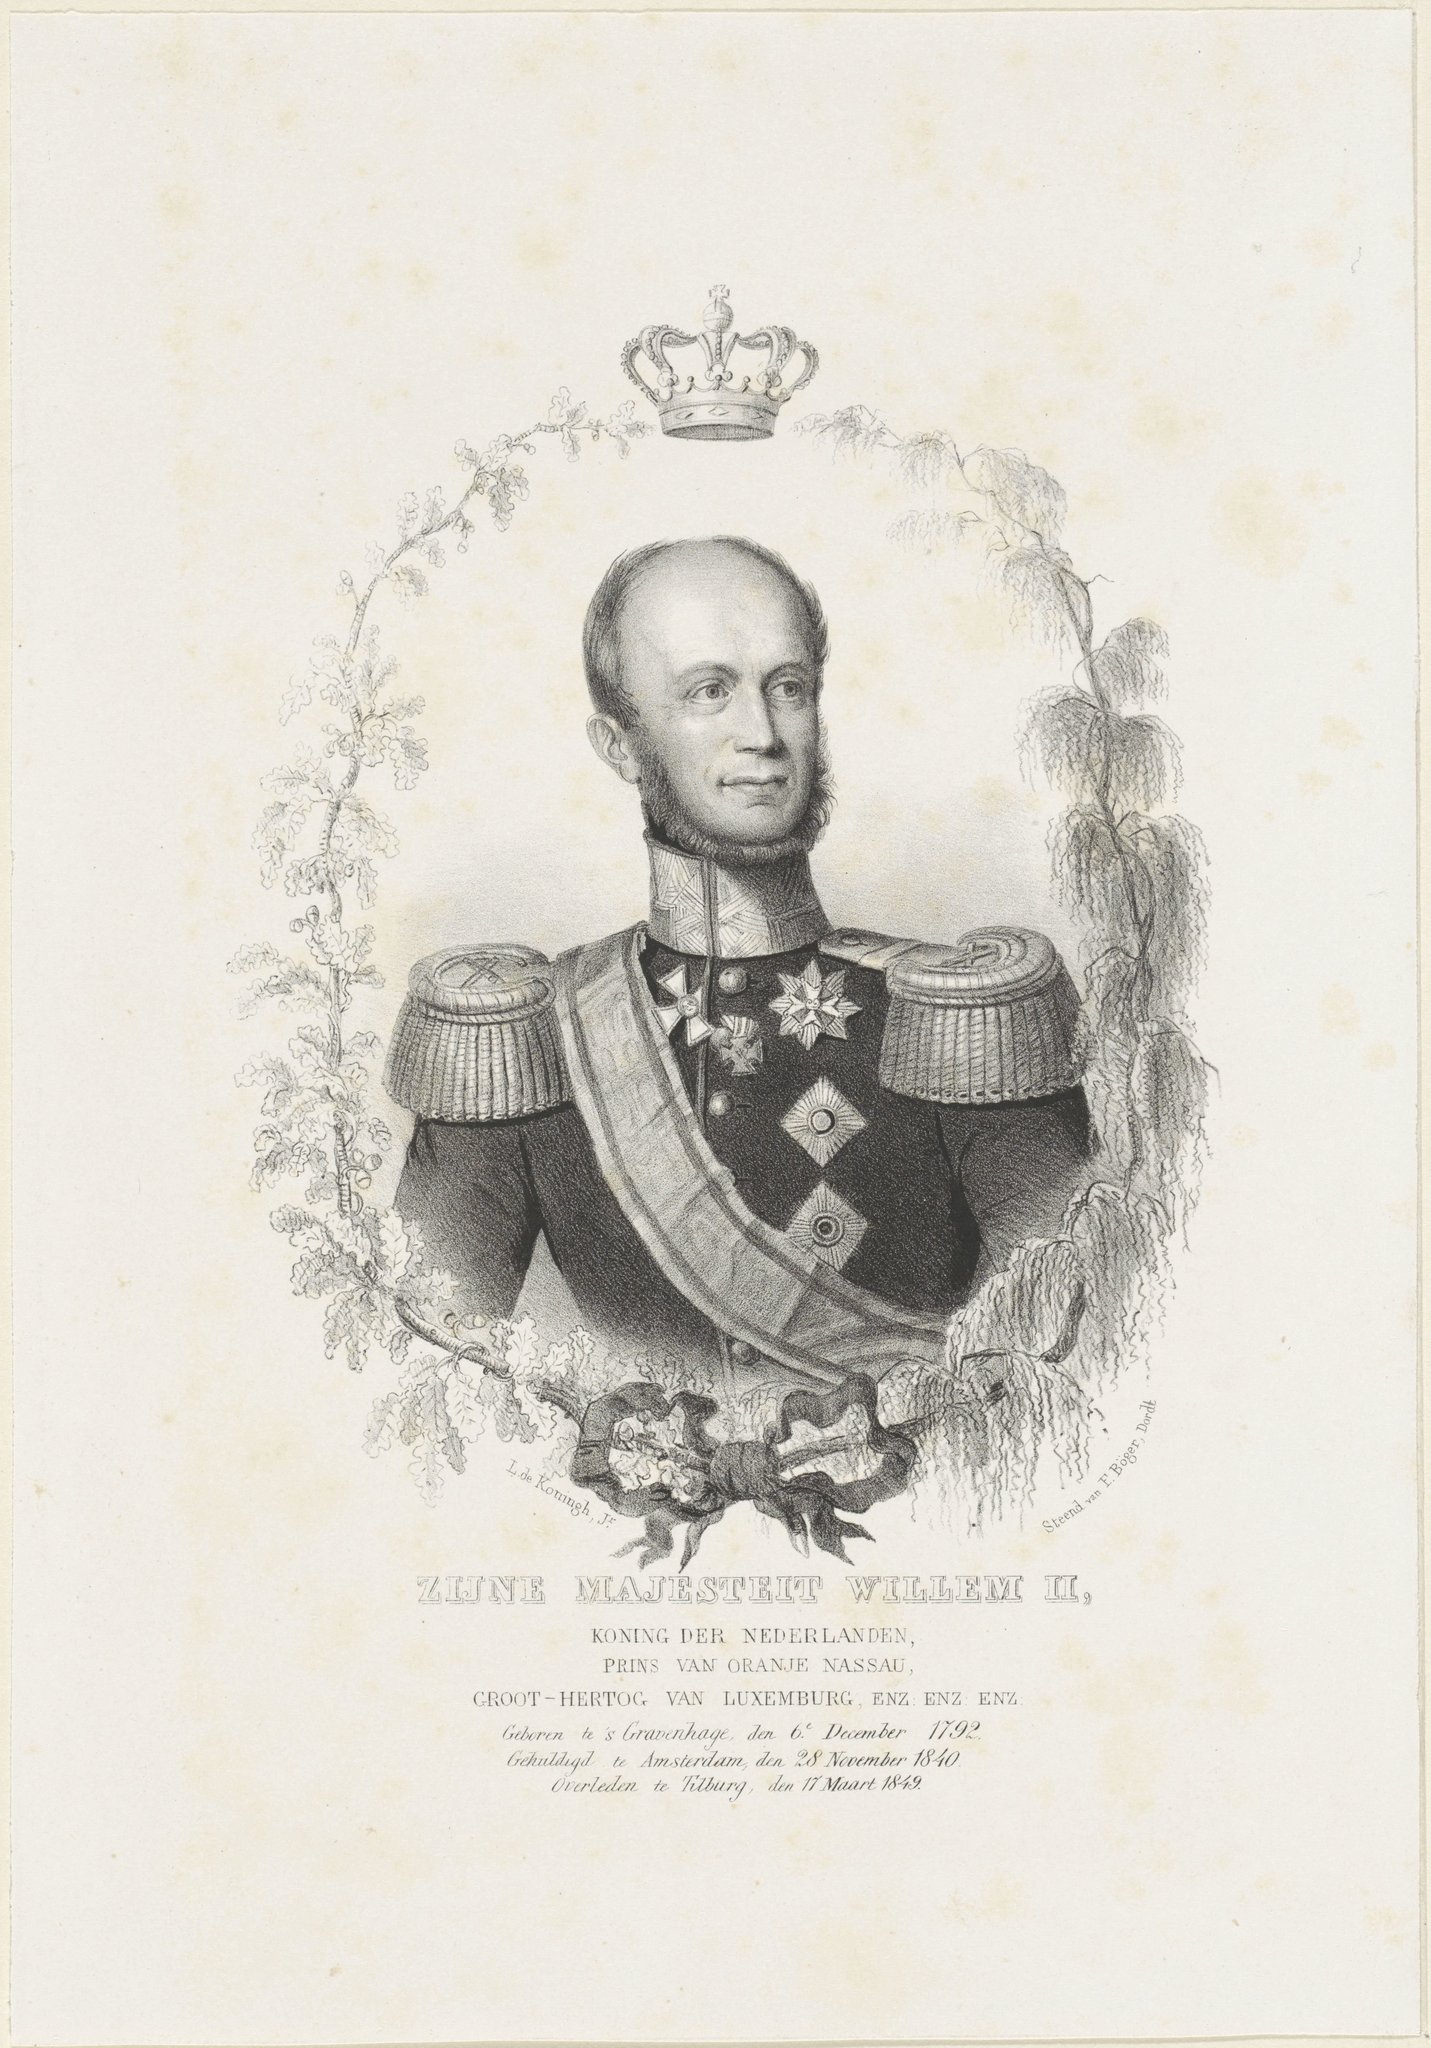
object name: print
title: Portret van Willem II, koning der Nederlanden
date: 1849-1880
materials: paper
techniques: lithograph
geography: dordrecht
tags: the hague, william ii of the netherlands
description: Portret van Willem II in een ovaal van treurwilgtakken. Midden boven een kroon. Midden onder een strik. In de ondermarge zijn naam, zijn titels en drie regels Nederlandse tekst.